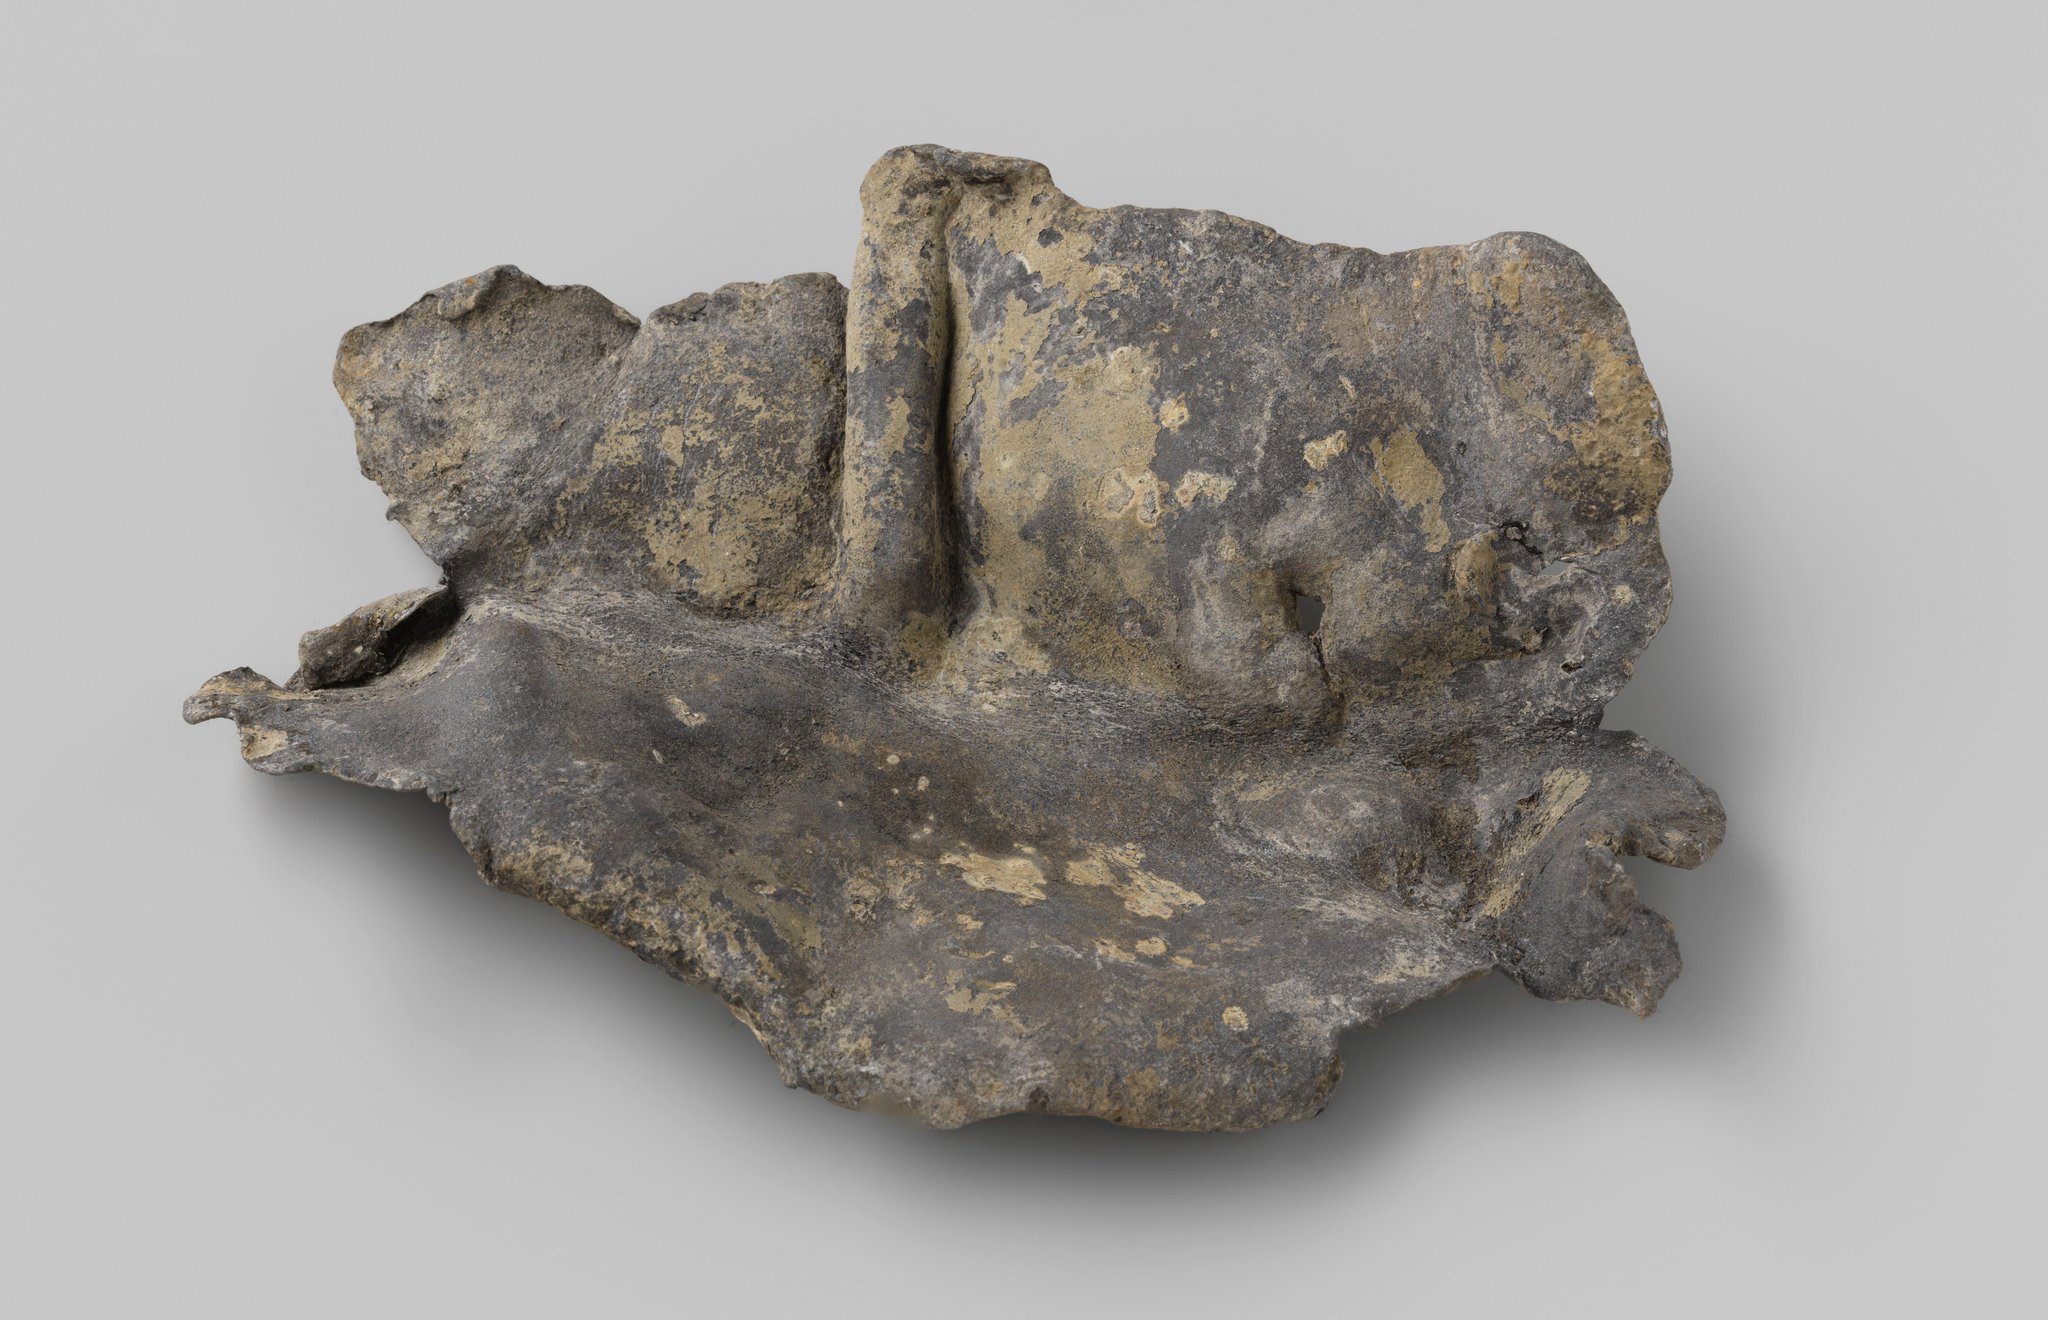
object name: fragment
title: Fragment van lood uit het wrak van de Oost-Indiëvaarder Hollandia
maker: Anonymous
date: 1700-1743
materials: lead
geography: netherlands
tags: verenigde oostindische compagnie, hollandia (schip), annet